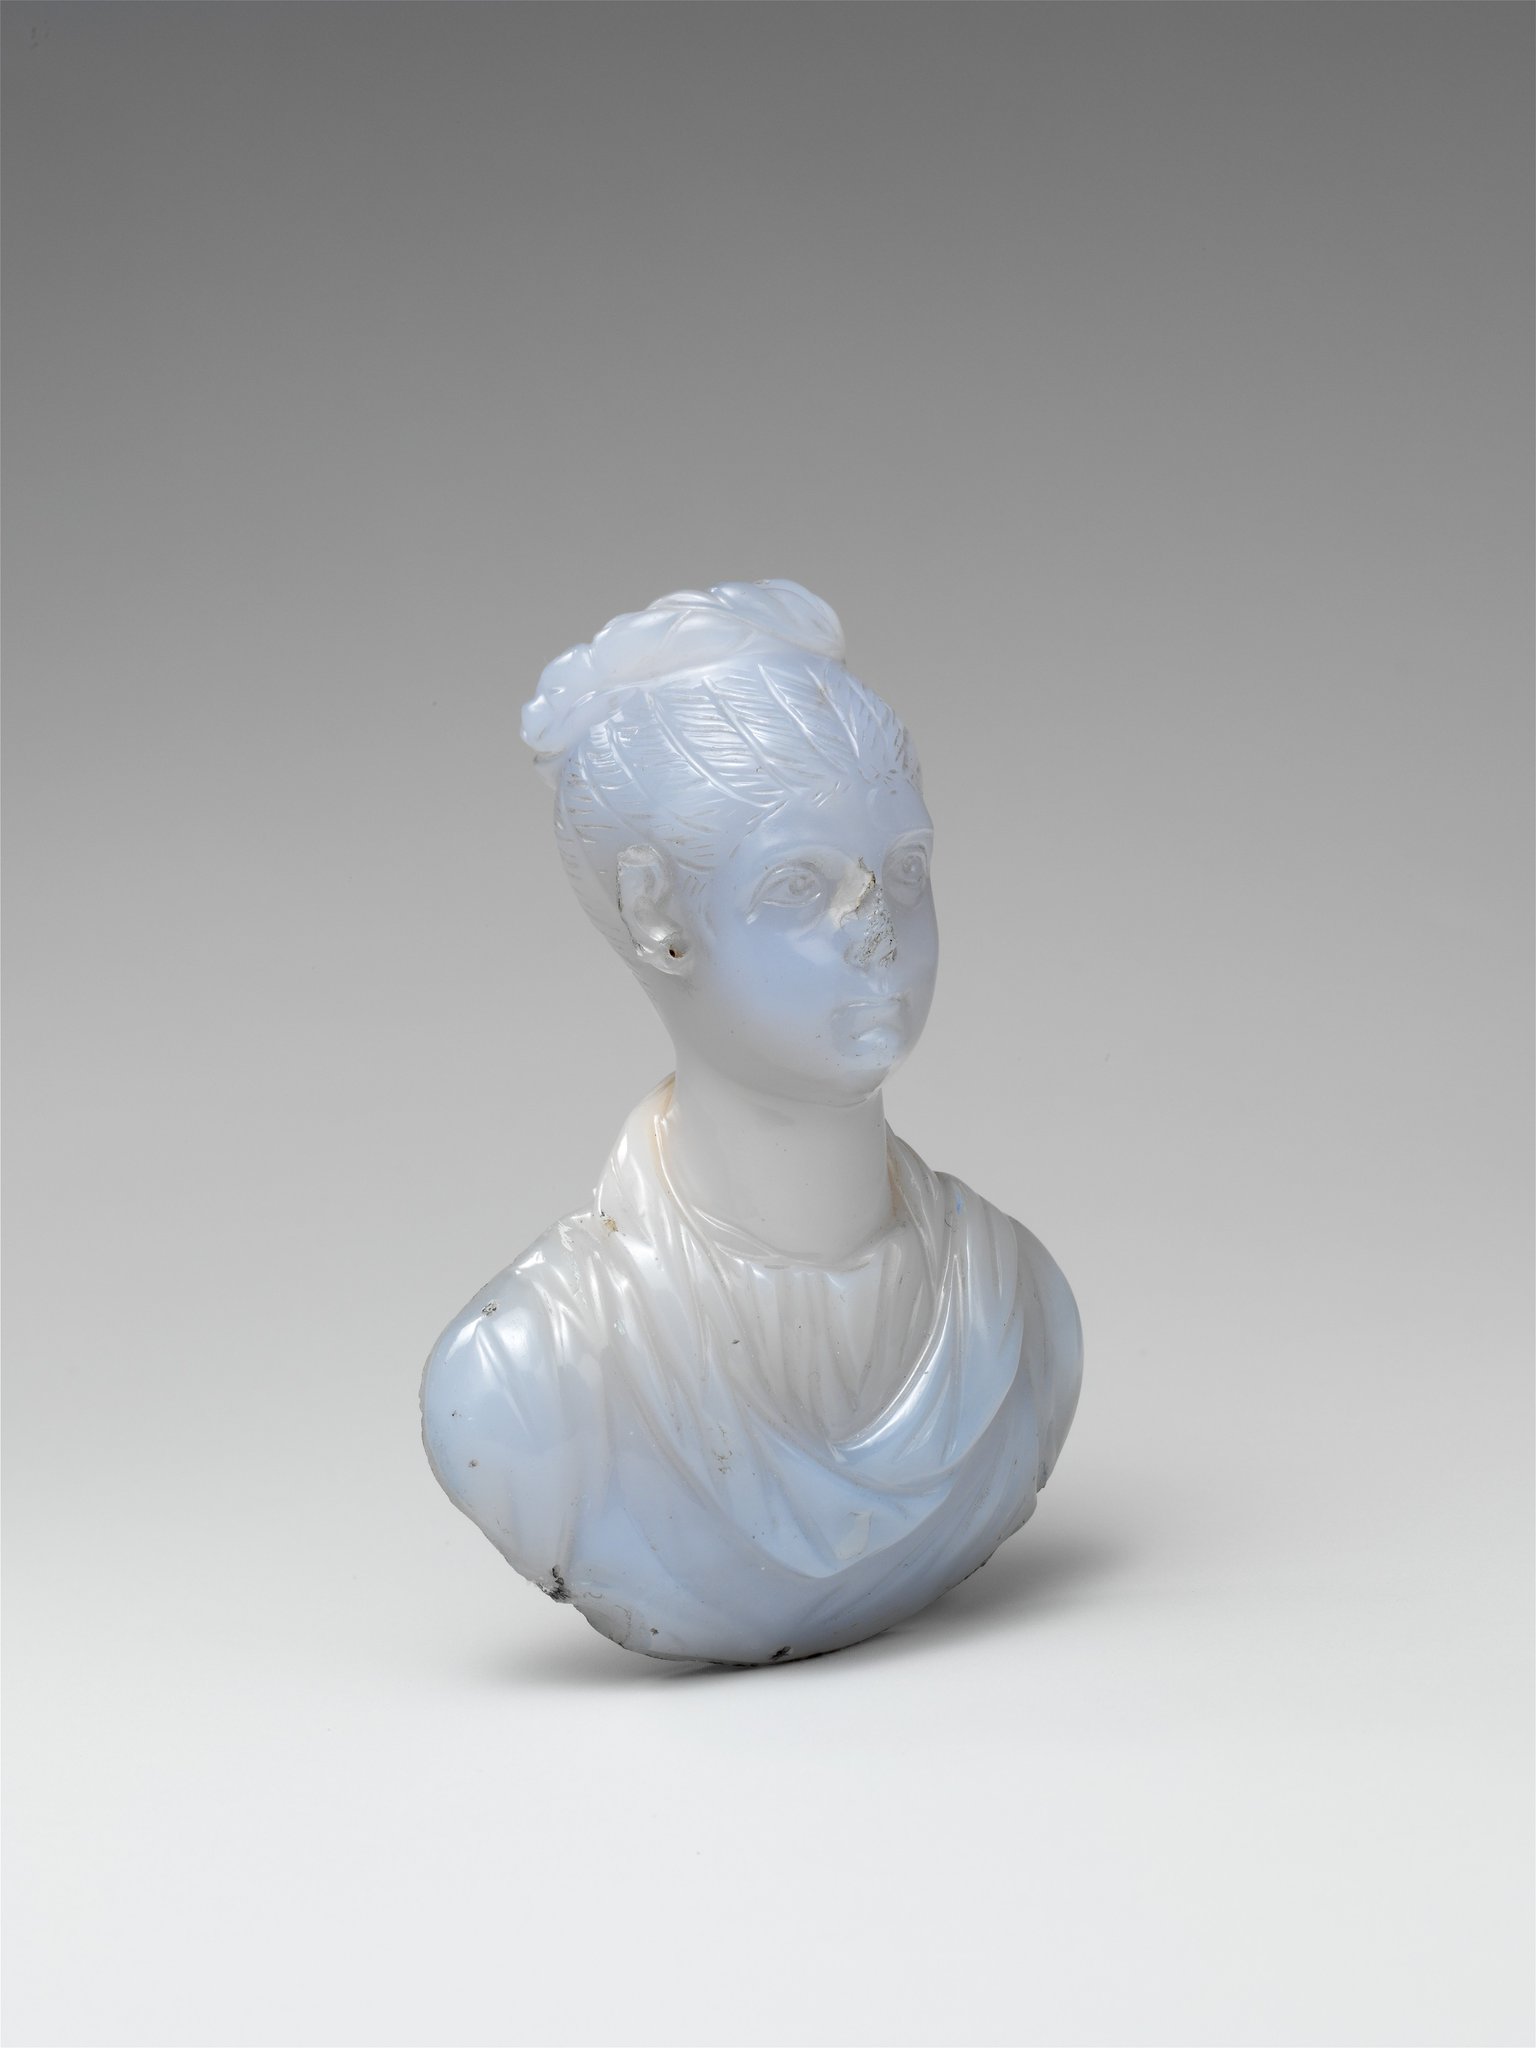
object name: portrait bust, girl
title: Chalcedony portrait bust of a young woman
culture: roman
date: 130-140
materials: stone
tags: portraits,women